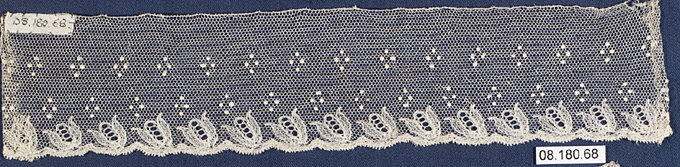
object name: fragment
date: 1801-1900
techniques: lace